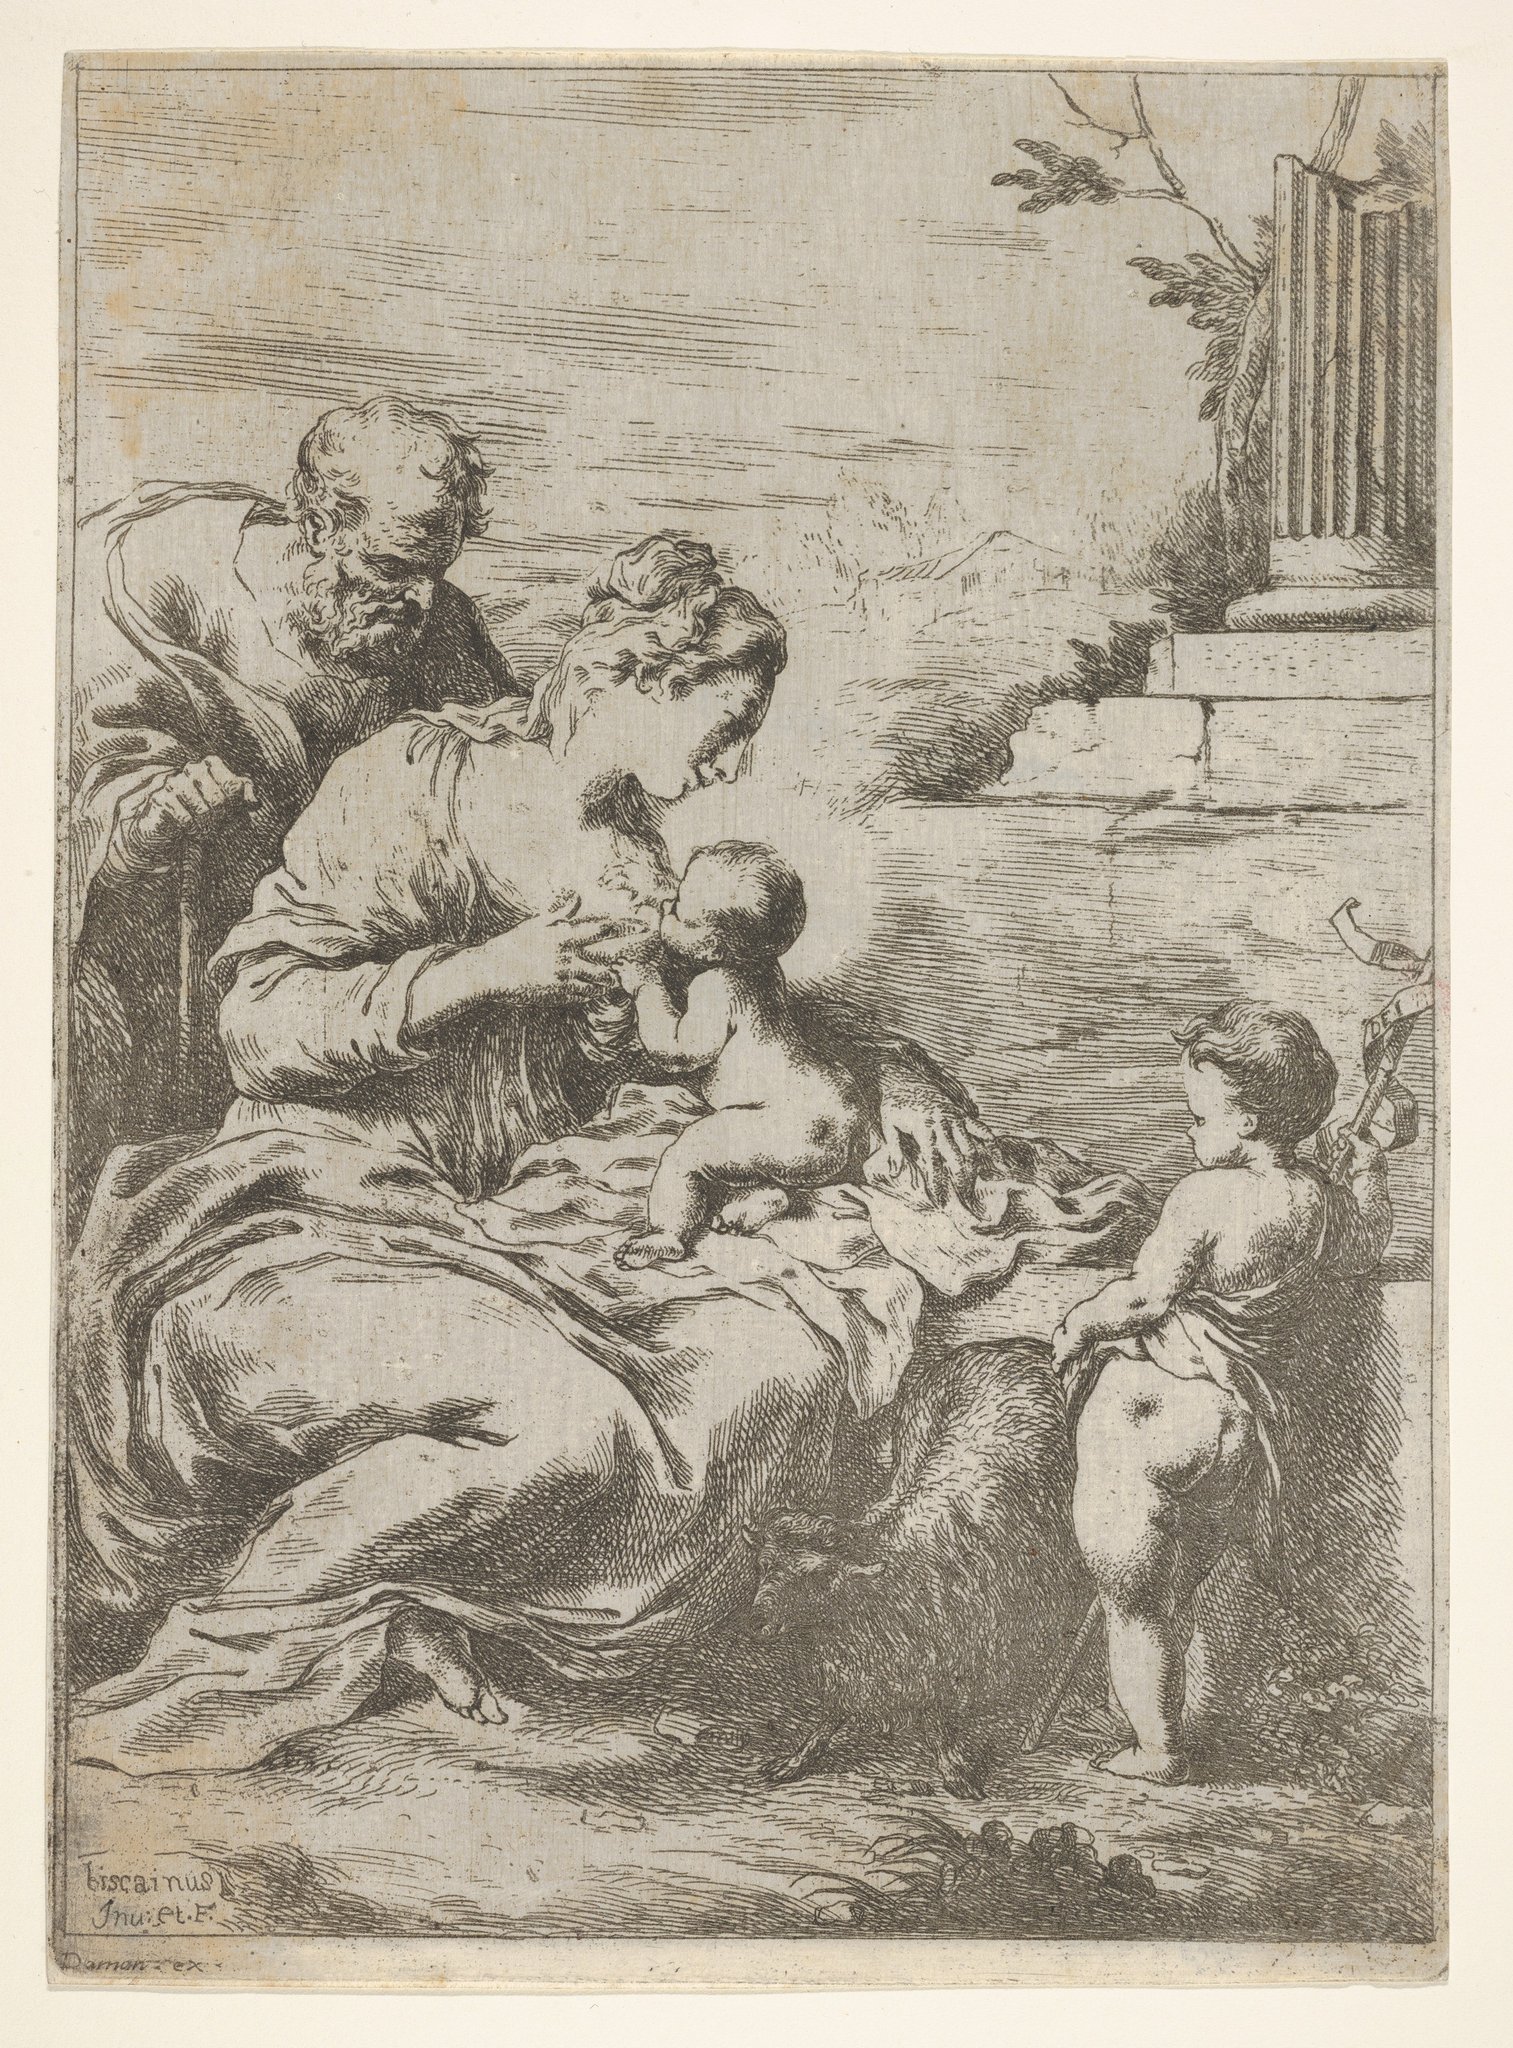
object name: print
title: The Holy Family with the infant St John the Baptist at right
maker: bartolomeo biscaino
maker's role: artist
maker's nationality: italian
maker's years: 1632-1657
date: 1650-1657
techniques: etching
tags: holy family,saint john the baptist